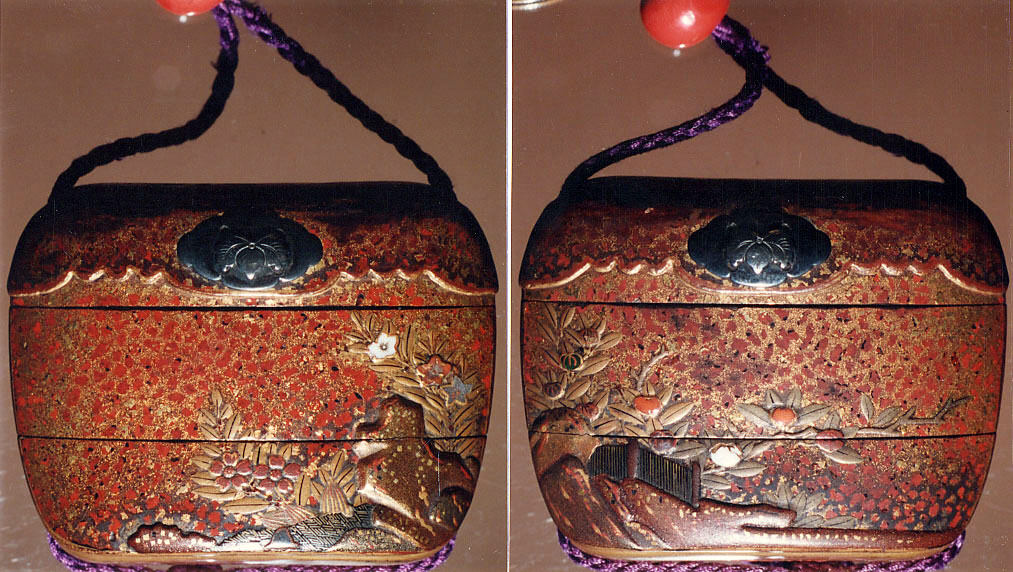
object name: inrō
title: Case (Inrō) with Design of Various Flowers Growing beside Rocks and Fence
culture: japanese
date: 1601-1800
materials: coral, gold, lacquer, metal, silver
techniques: fundame, hiramakie, inlay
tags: flowers